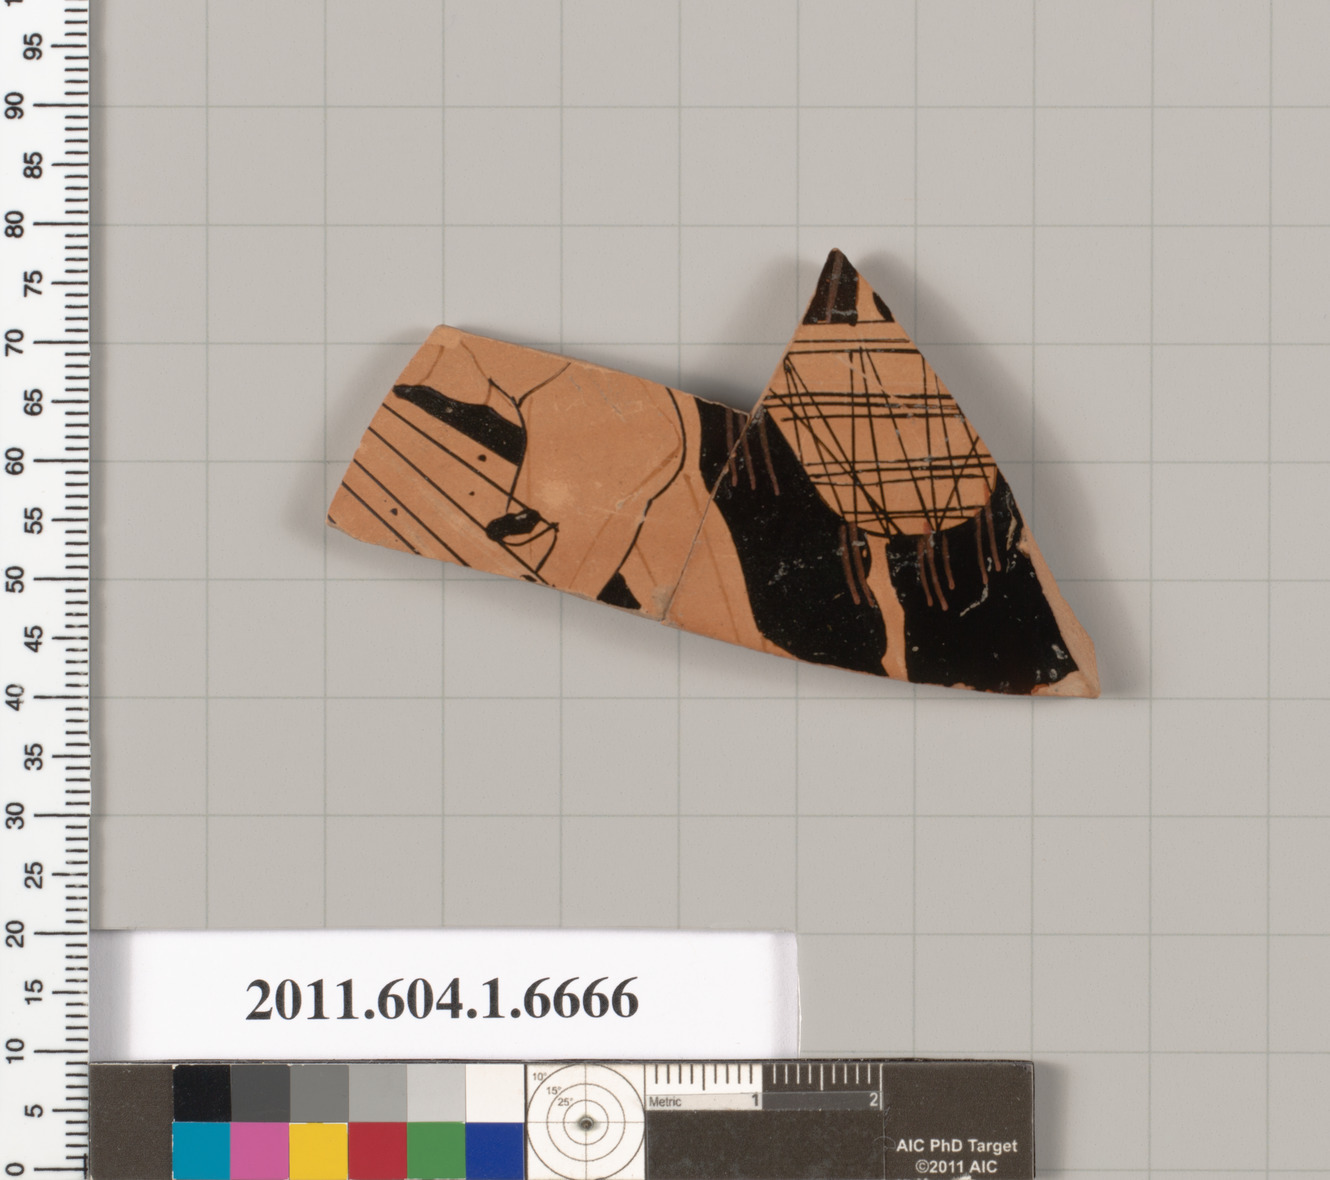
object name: kylix fragment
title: Terracotta fragment of a kylix (drinking cup)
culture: greek, attic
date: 490-470 BCE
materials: terracotta